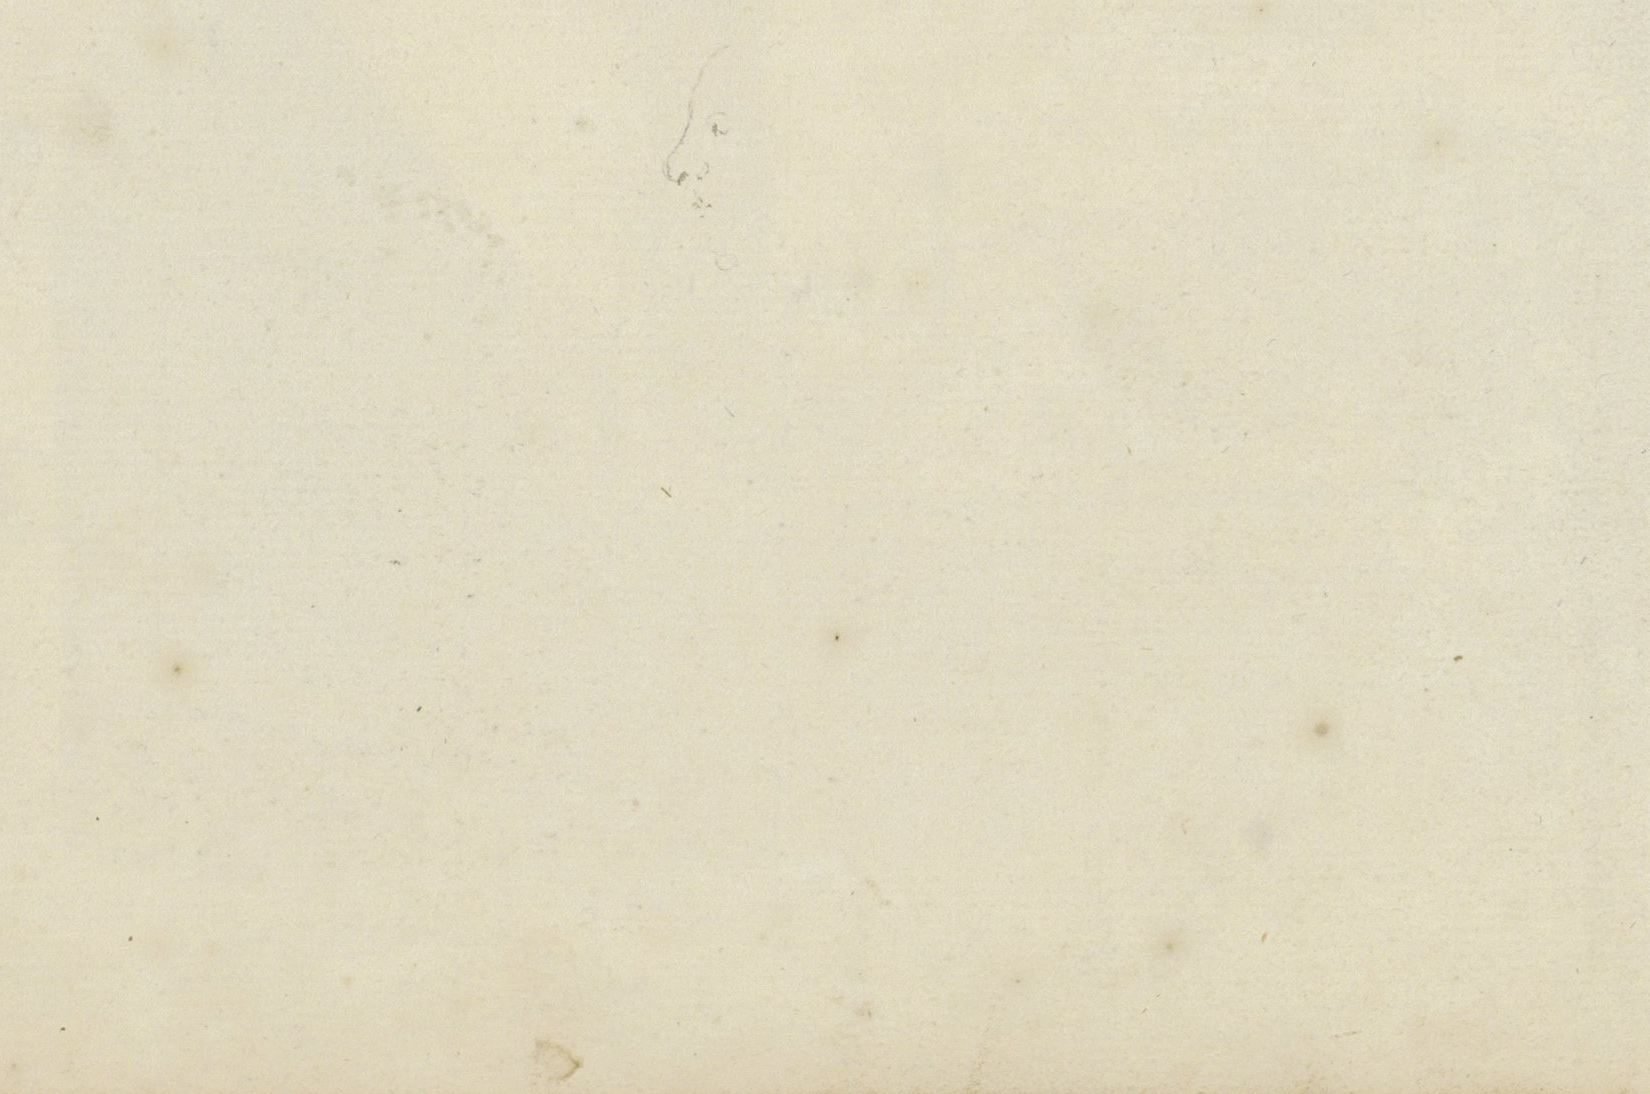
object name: sketchbook leaf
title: Gezicht in profiel naar links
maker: abraham de haen (ii)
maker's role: draughtsman, print maker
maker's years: 1707-1748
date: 1717-1748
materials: paper, pencil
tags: face (+ left side visible; left - (l. hand, l. foot, etc.))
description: Blad 8 verso uit een schetsboek met 21 bladen.